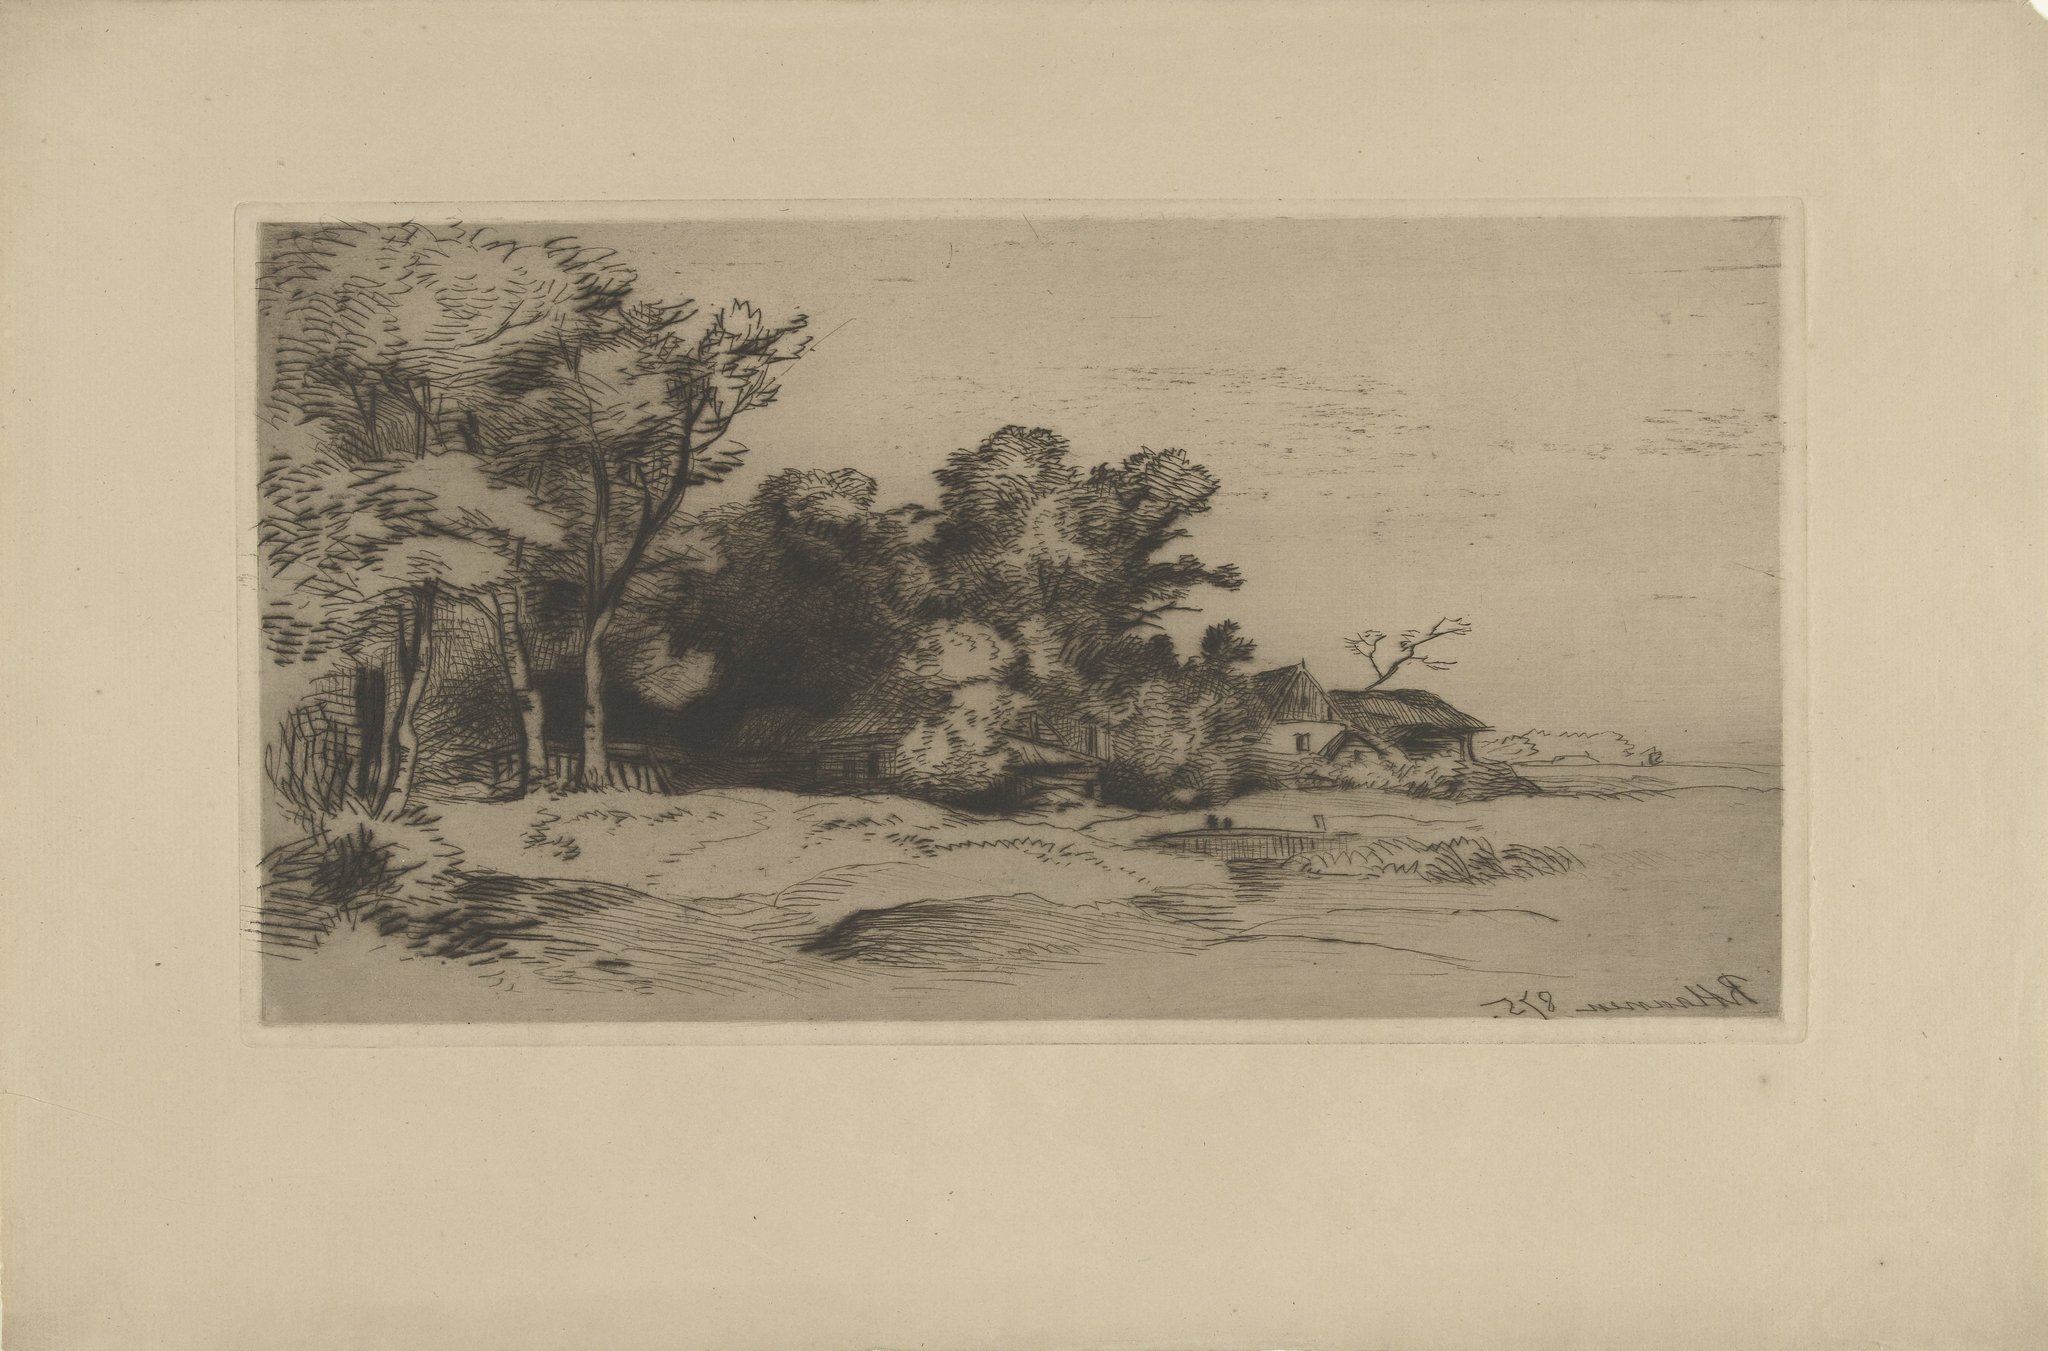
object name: print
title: Landschap met boerderij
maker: remigius adrianus haanen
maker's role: draughtsman, painter, print maker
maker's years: 1812-1894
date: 1875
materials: paper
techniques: drypoint, etching, intaglio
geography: austria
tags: farm or solitary house in landscape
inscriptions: collector's mark: Lugt 2228, collector's mark: Lugt 2760, name: ‘Remigius Adrianus (van) Haanen’